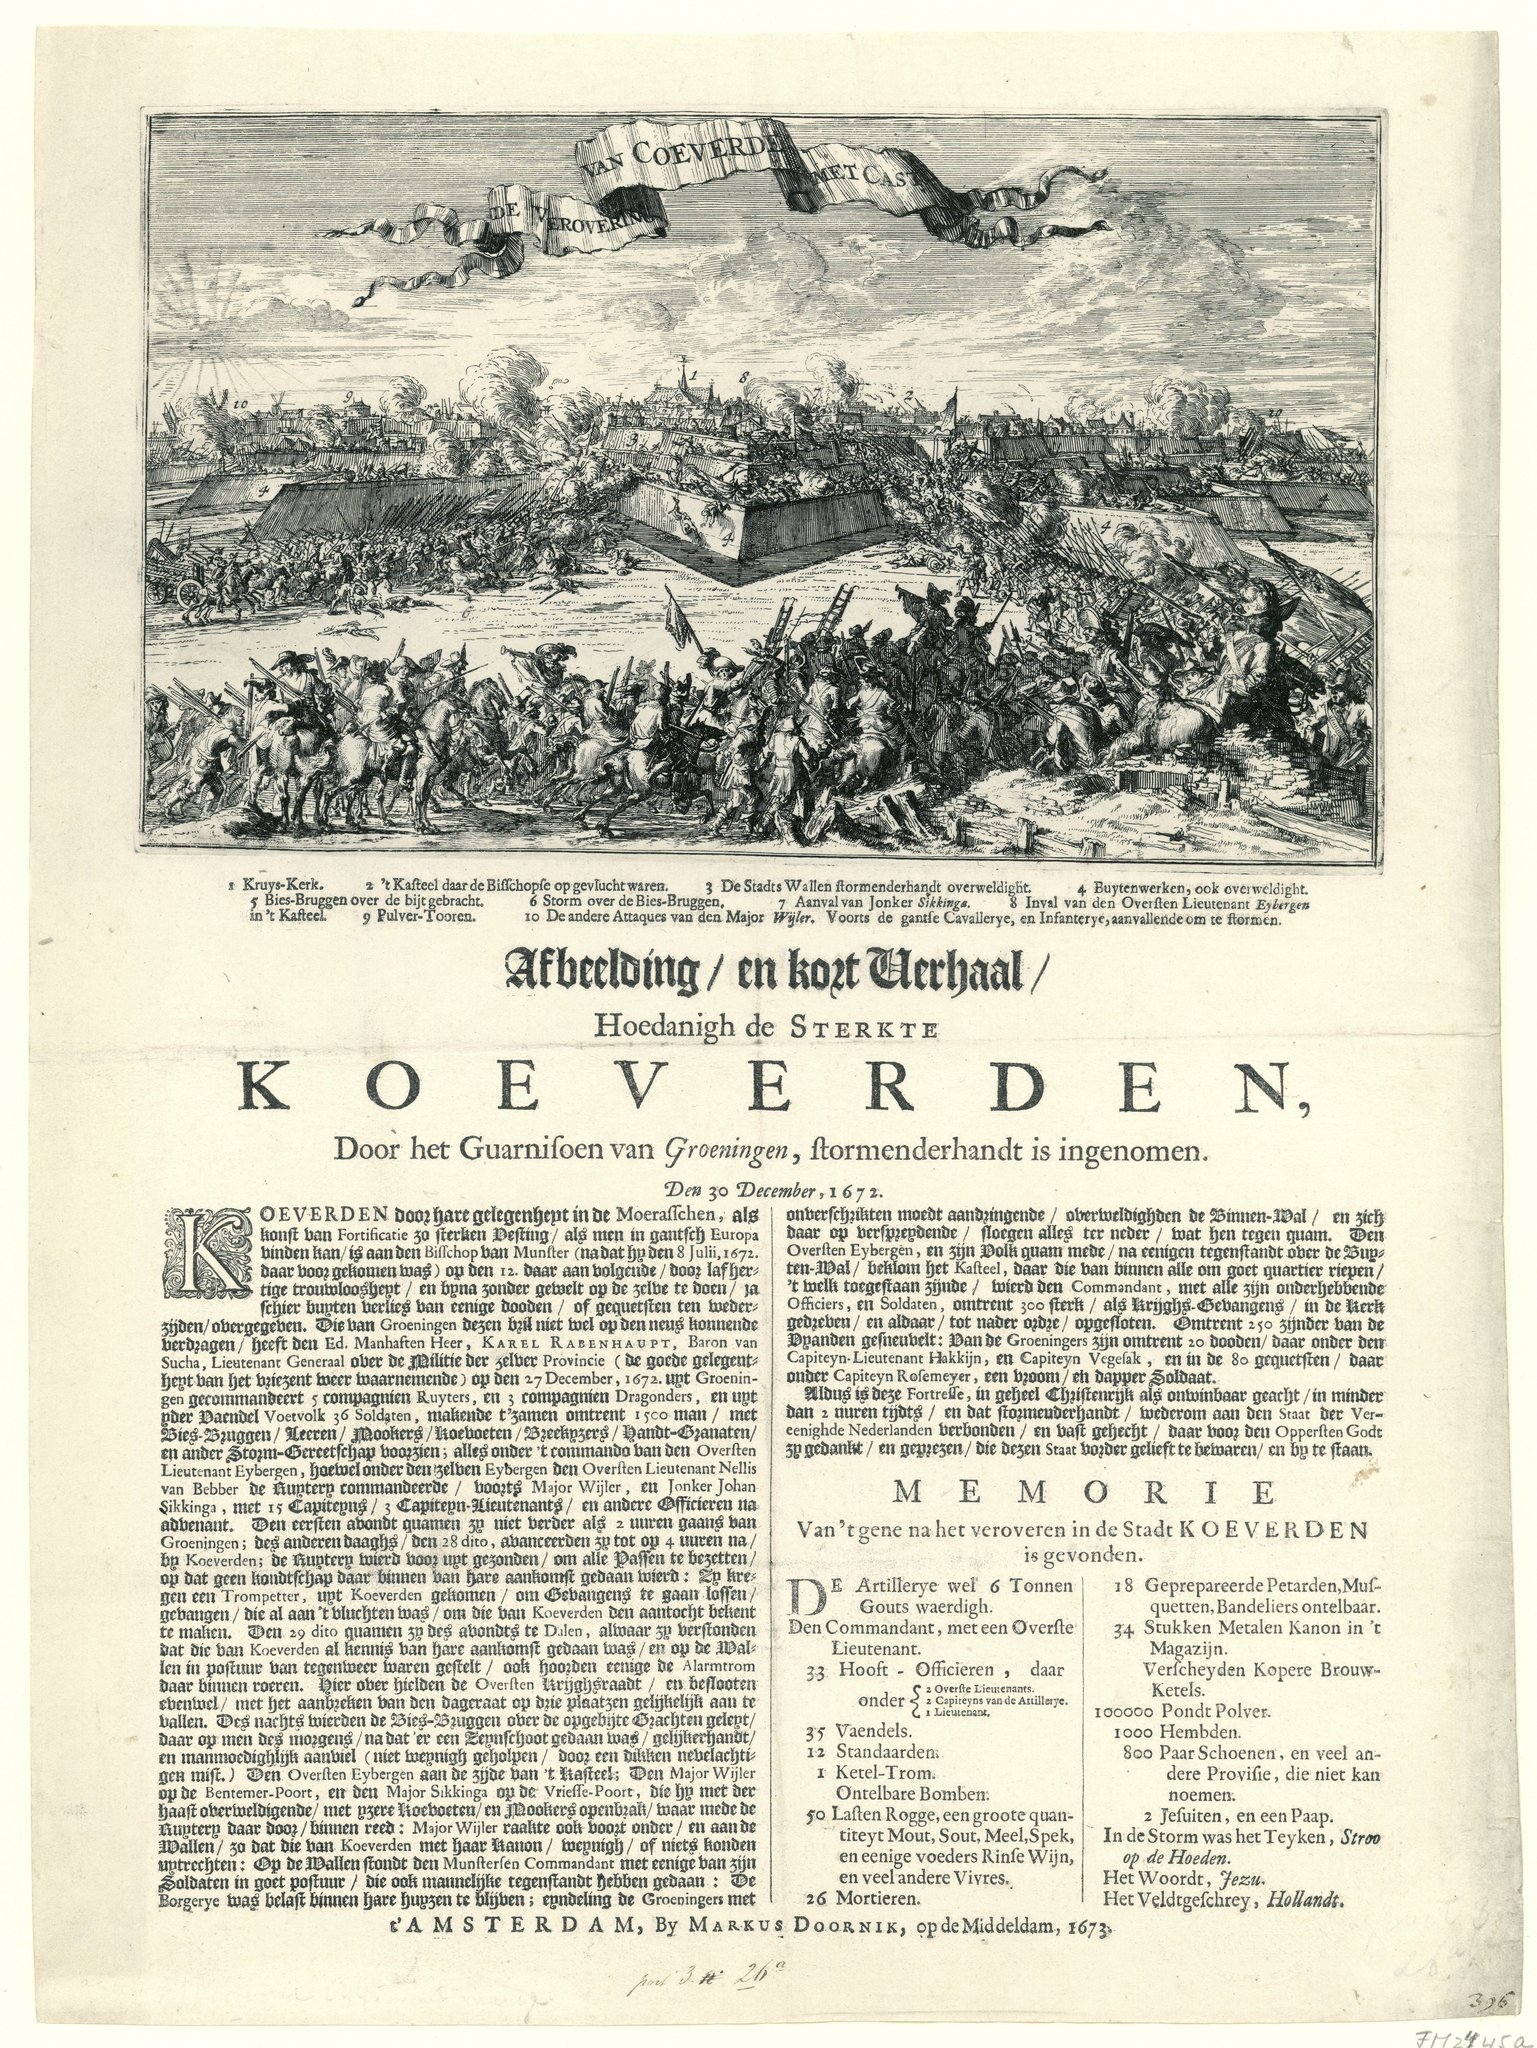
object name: print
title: Afbeelding en kort Verhaal Hoedanigh de Sterkte Koeverden Door het Guarnisoen van Groeningen, stormenderhandt is ingenomen. Den 30 December 1672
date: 1673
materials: paper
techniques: etching, letterpress printing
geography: amsterdam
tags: capture of city (after the siege)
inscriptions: collector's mark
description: Blad met een voorstelling en beschrijving van de verovering van Coevorden op 30 december 1672 op de troepen van de bisschop van Munster, door de troepen onder leiding van Karl Rabenhaupt. Genummerde details worden in de legenda onder de voorstelling verklaard. Hieronder een beschrijving van het verloop van de strijd over twee kolommen in het Nederlands. Op het eind een overzicht van de gemaakte gevangenen en de veroverde buit.